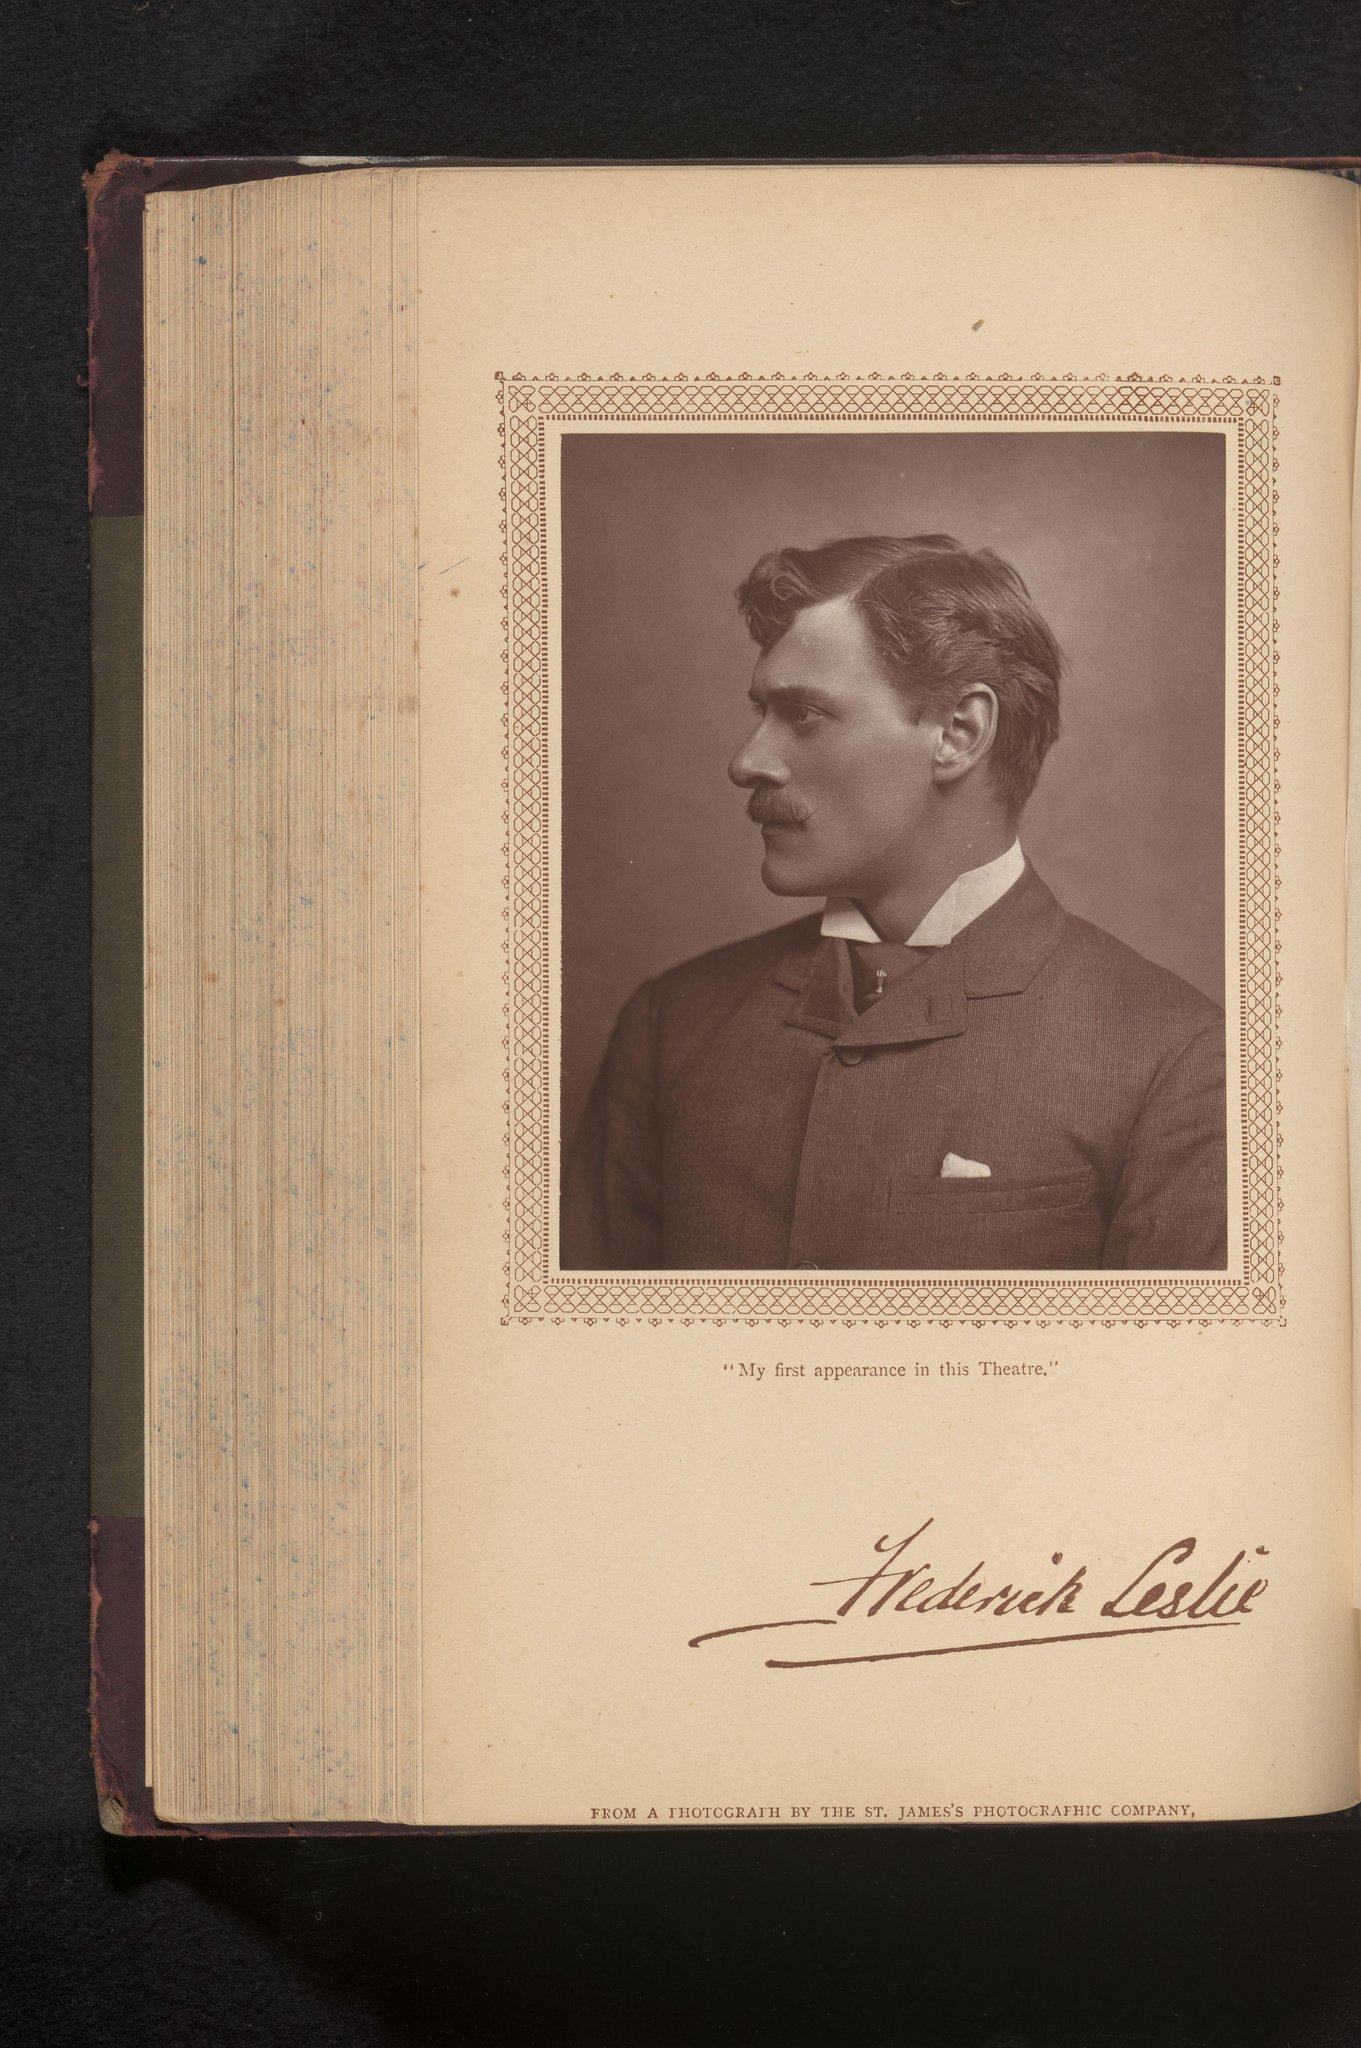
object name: photomechanical print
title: Portret van Frederick Hobson Leslie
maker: Anonymous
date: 1879-1884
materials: paper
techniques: woodburytype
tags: adult man, historical persons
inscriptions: signature: ‘Frederick Leslie’, inscription: ‘'My first appearance in this Theatre.'’